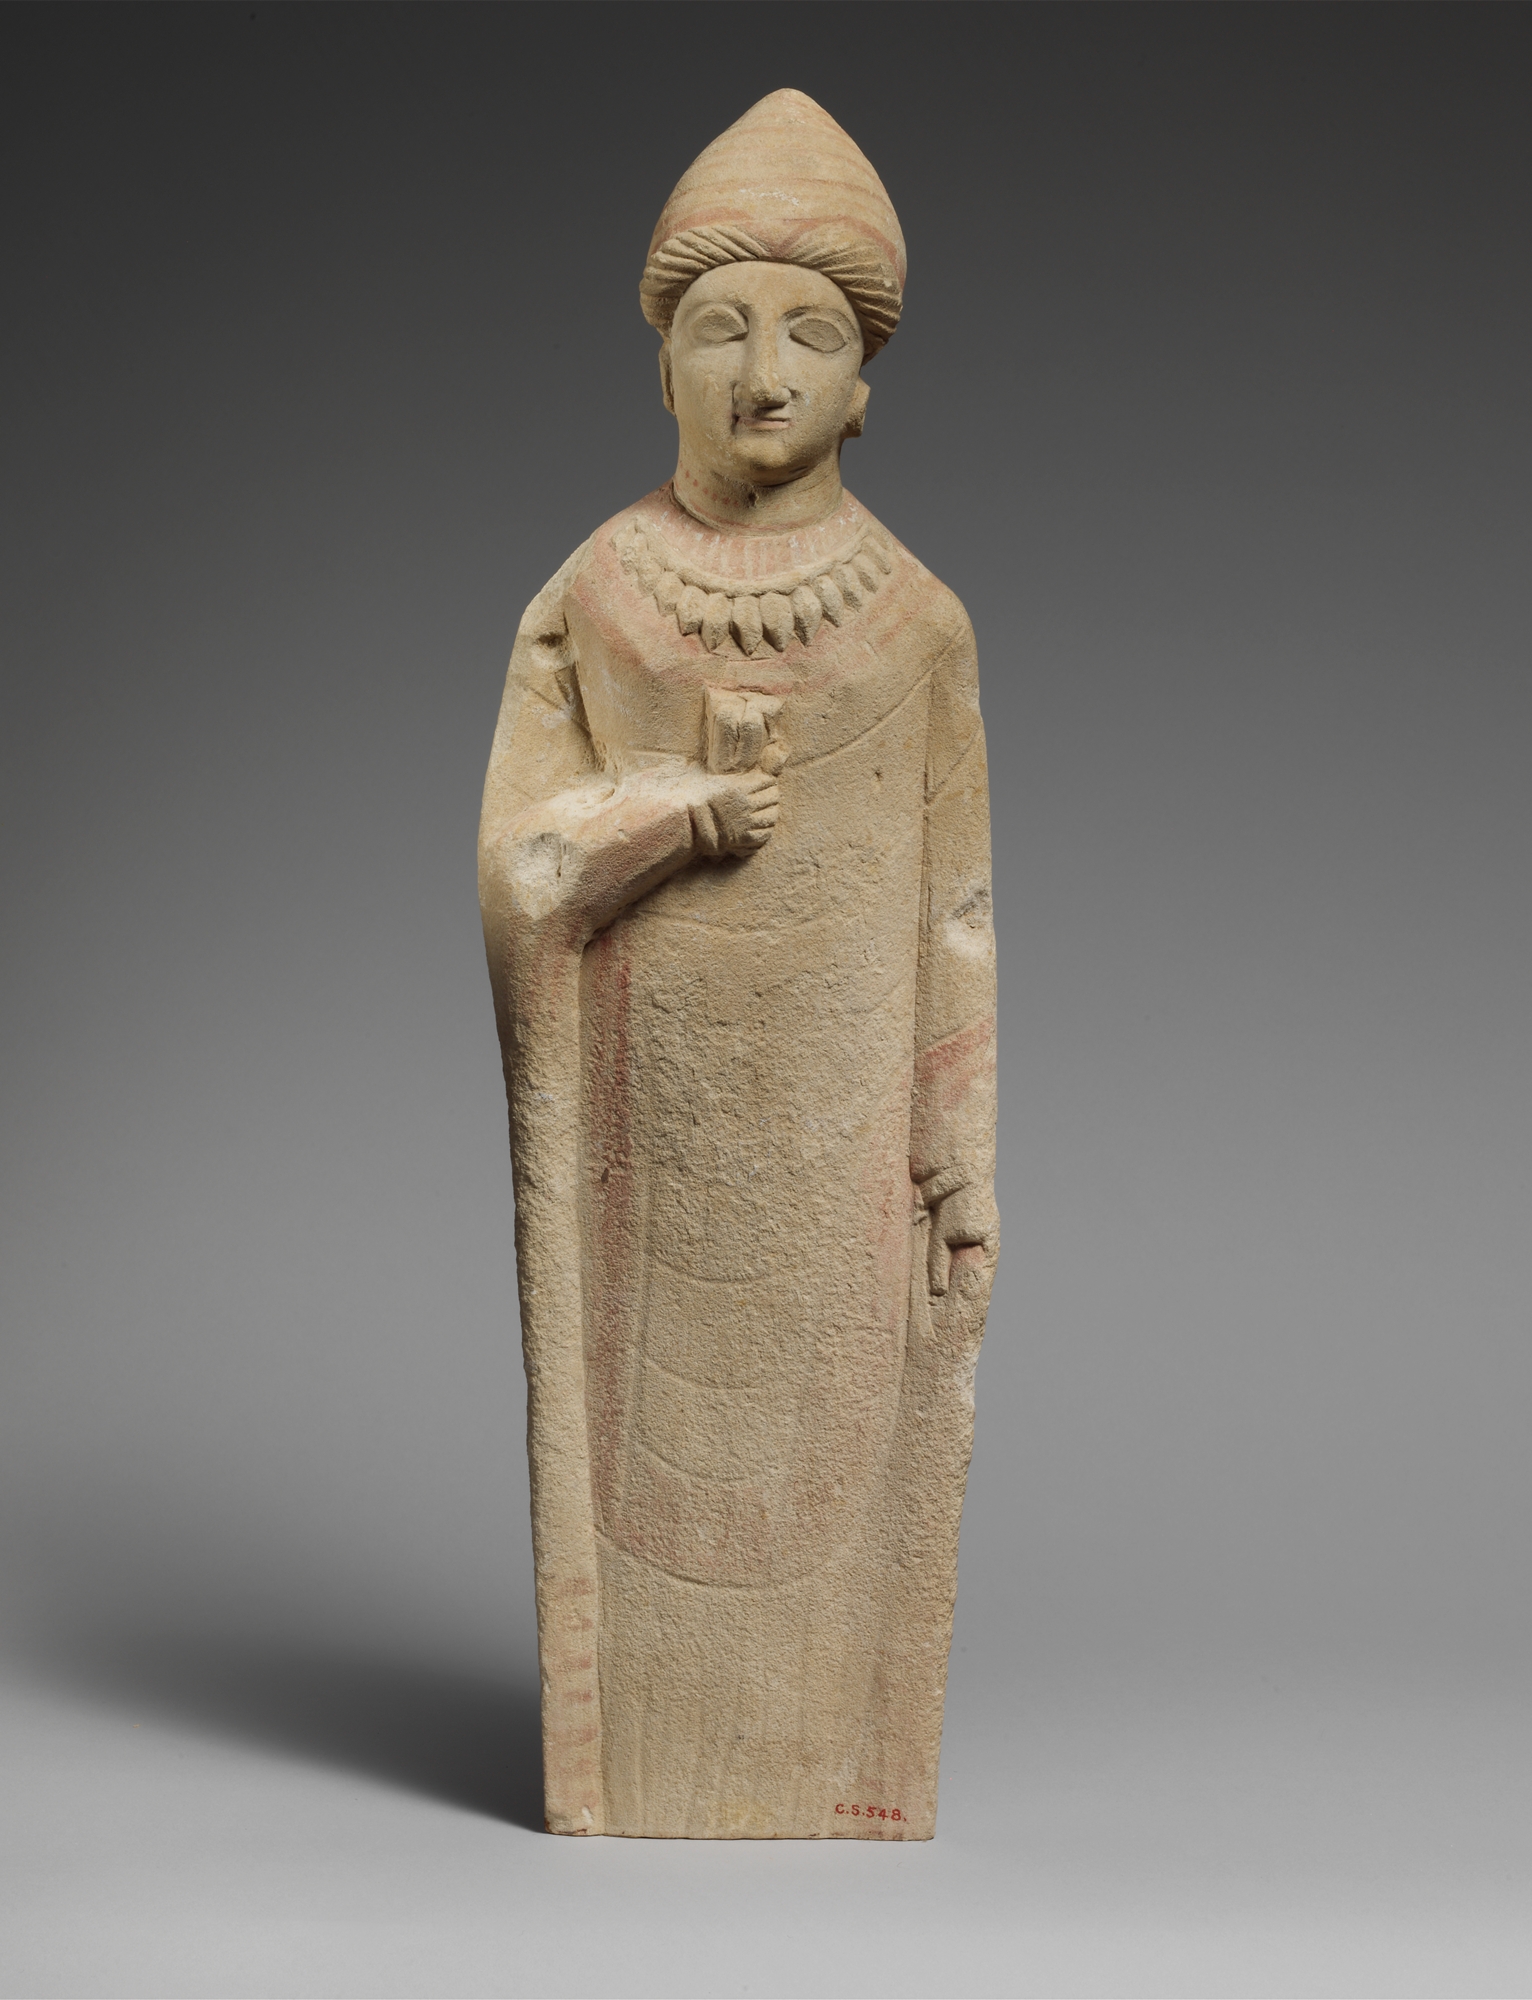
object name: statue of a votary, female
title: Limestone statuette of a female votary holding a flower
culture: cypriot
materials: limestone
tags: necklaces,women,flowers